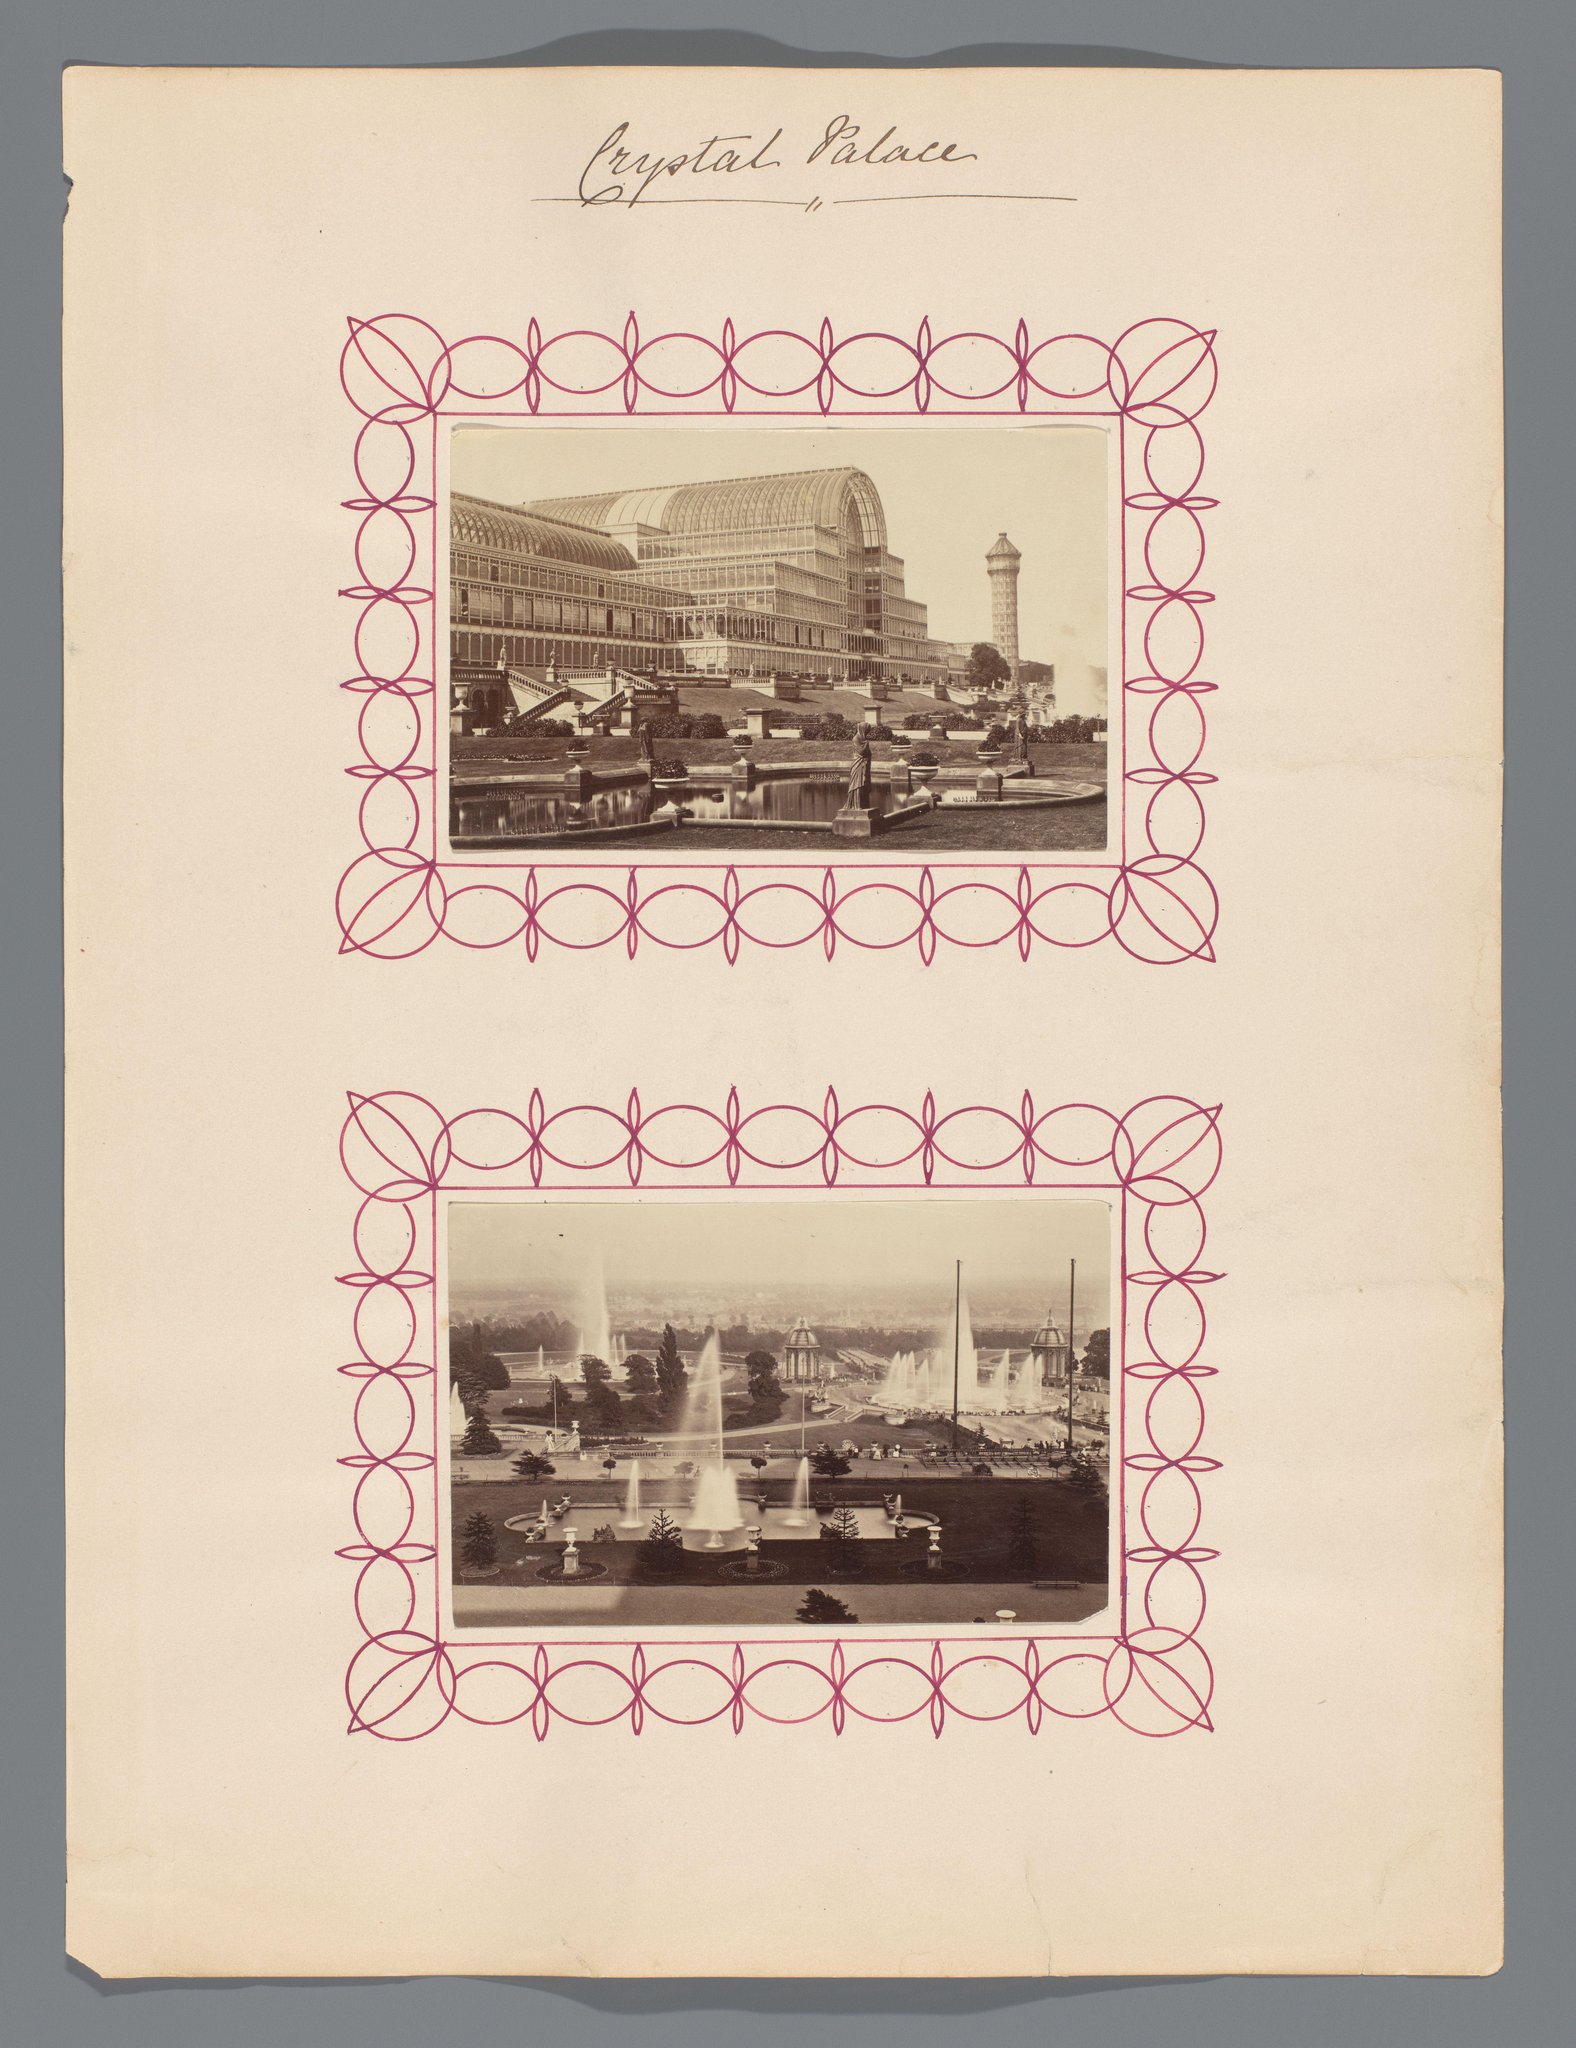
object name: photograph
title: Blad met twee foto's van Crystal Palace en randversiering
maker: Anonymous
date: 1860-1880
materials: ink, paper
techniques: albumen print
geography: london